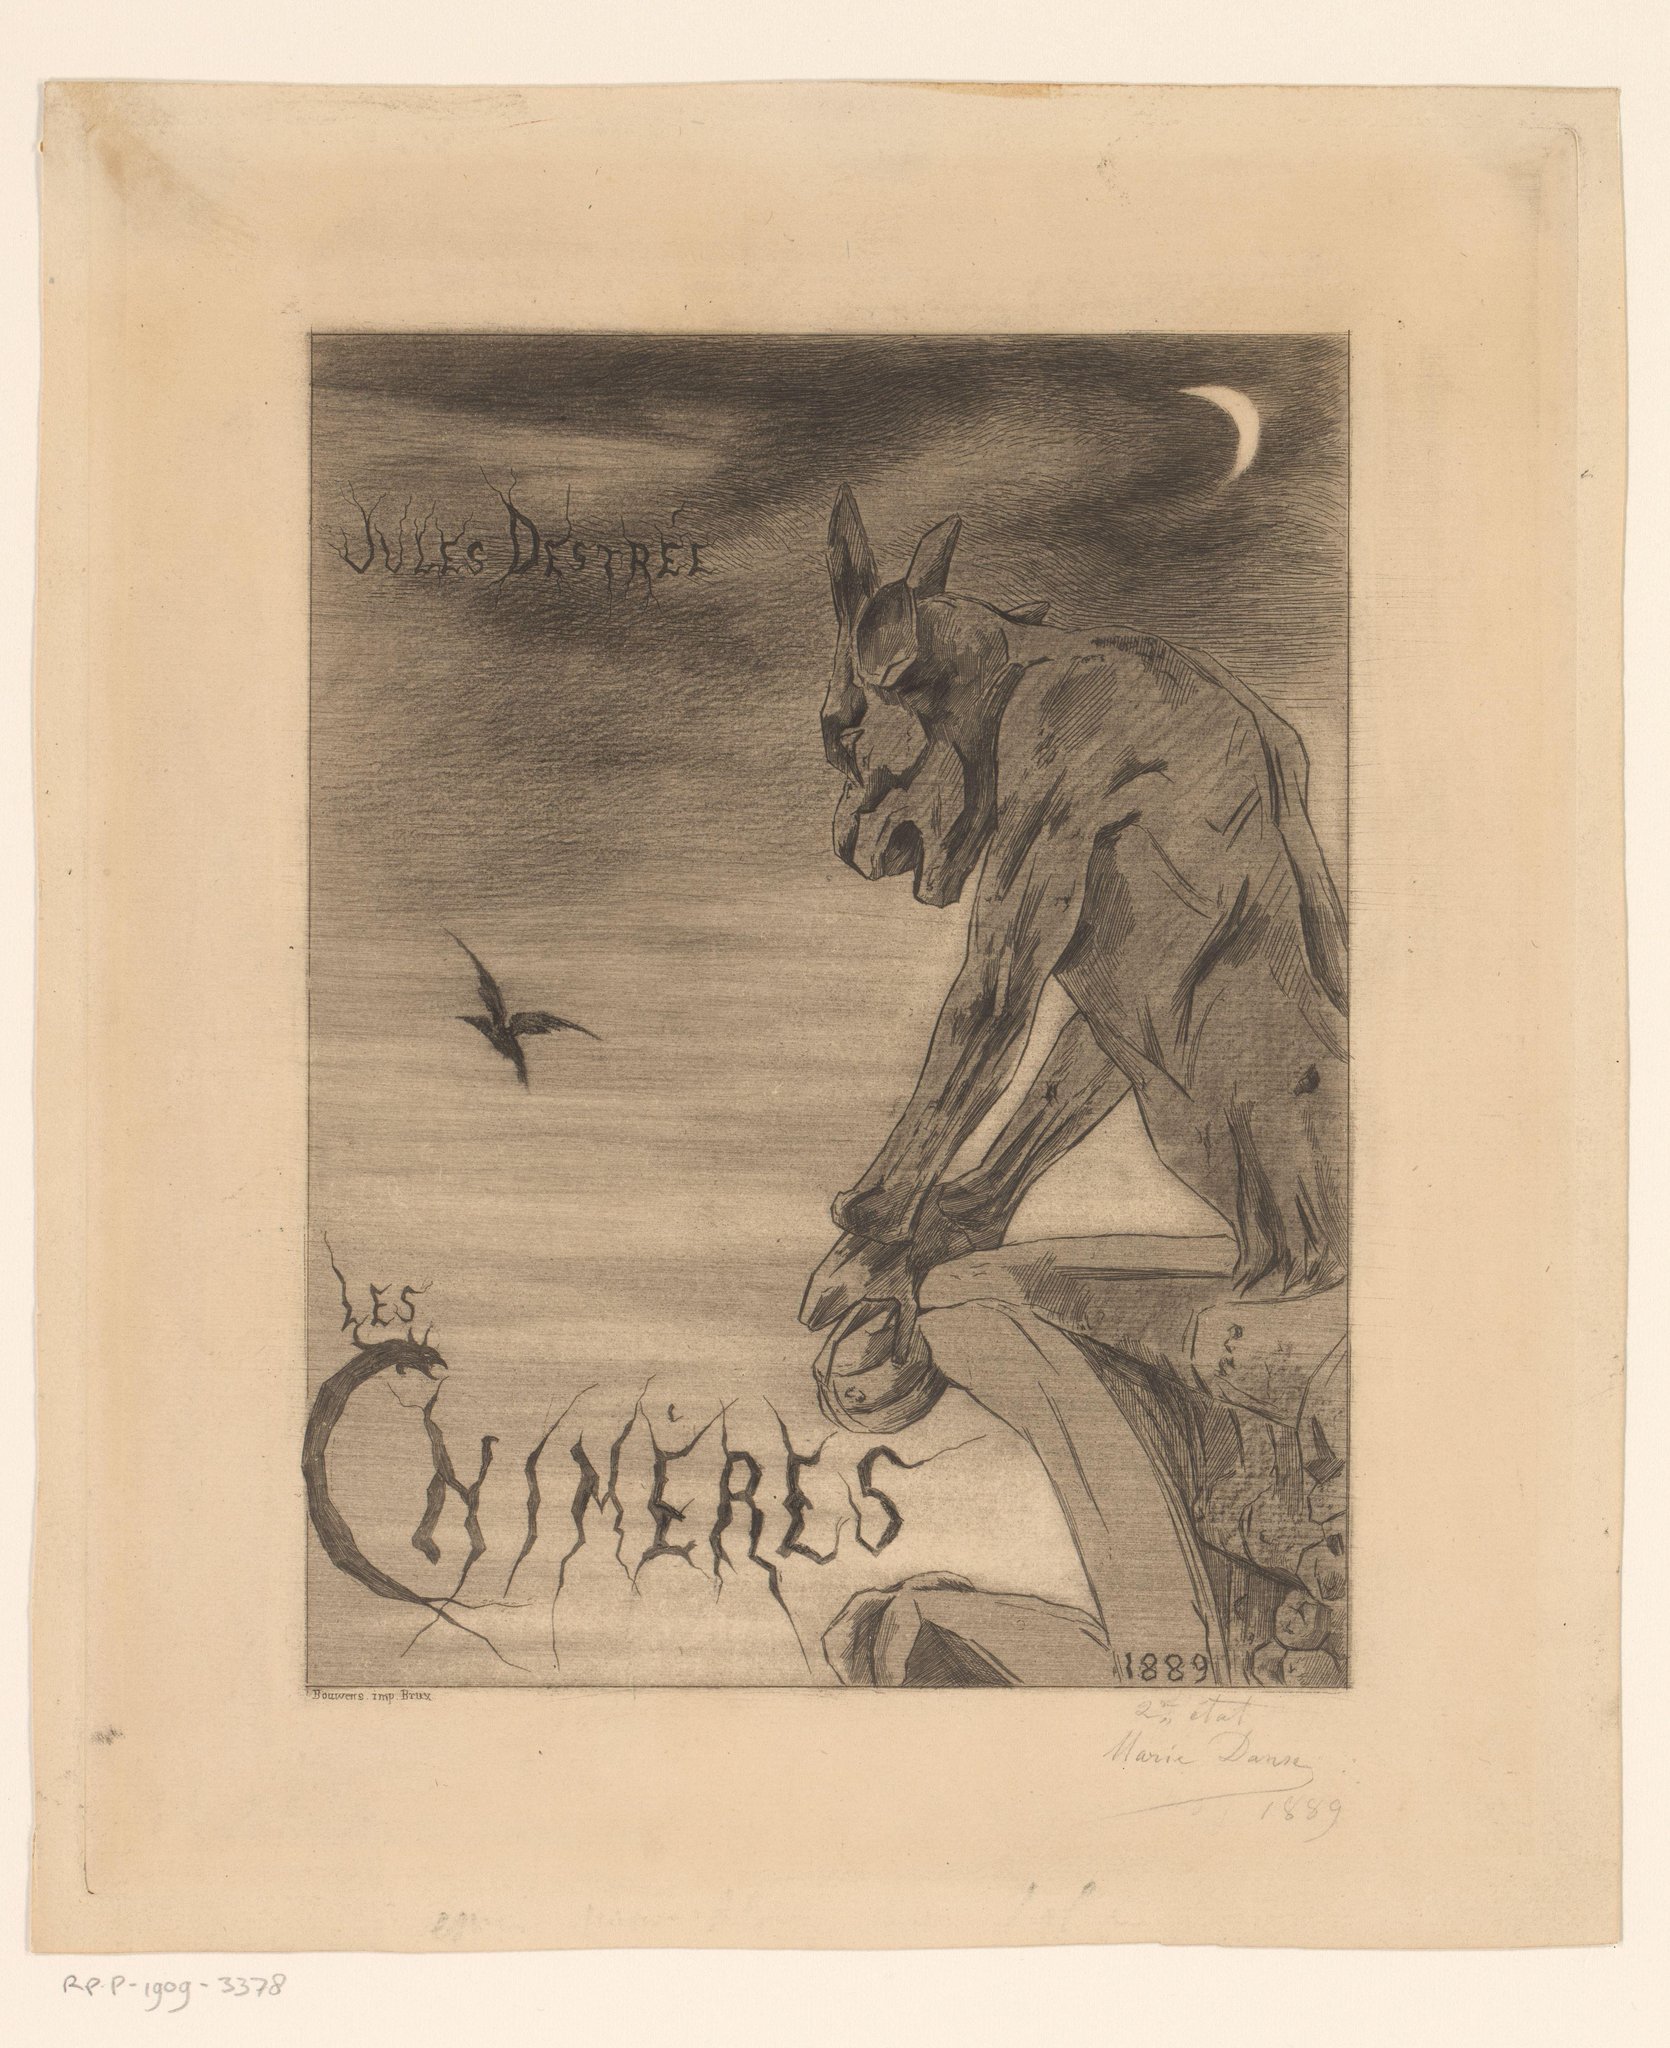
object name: titelblad, titelpagina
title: Waterspuwer van de Notre-Dame te Parijs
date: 1889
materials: paper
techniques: etching, intaglio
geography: brussels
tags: piece of sculpture, reproduction of a piece of sculpture, parts of church exterior and annexes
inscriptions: inscription: ‘2e état’, collector's mark: Lugt 2228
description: Titelpagina voor: Destrée, Jules. Les Chimères. Brussel: J. Bouwens, 1889.